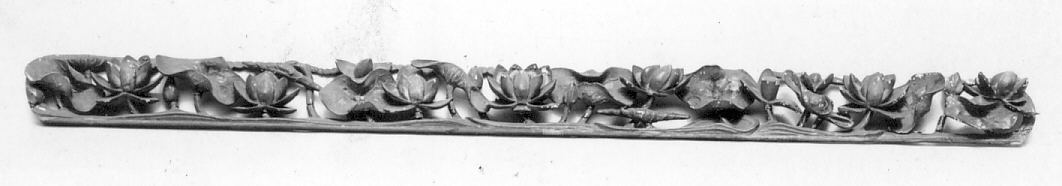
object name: wood carving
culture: japanese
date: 1601-1700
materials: wood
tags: lotuses